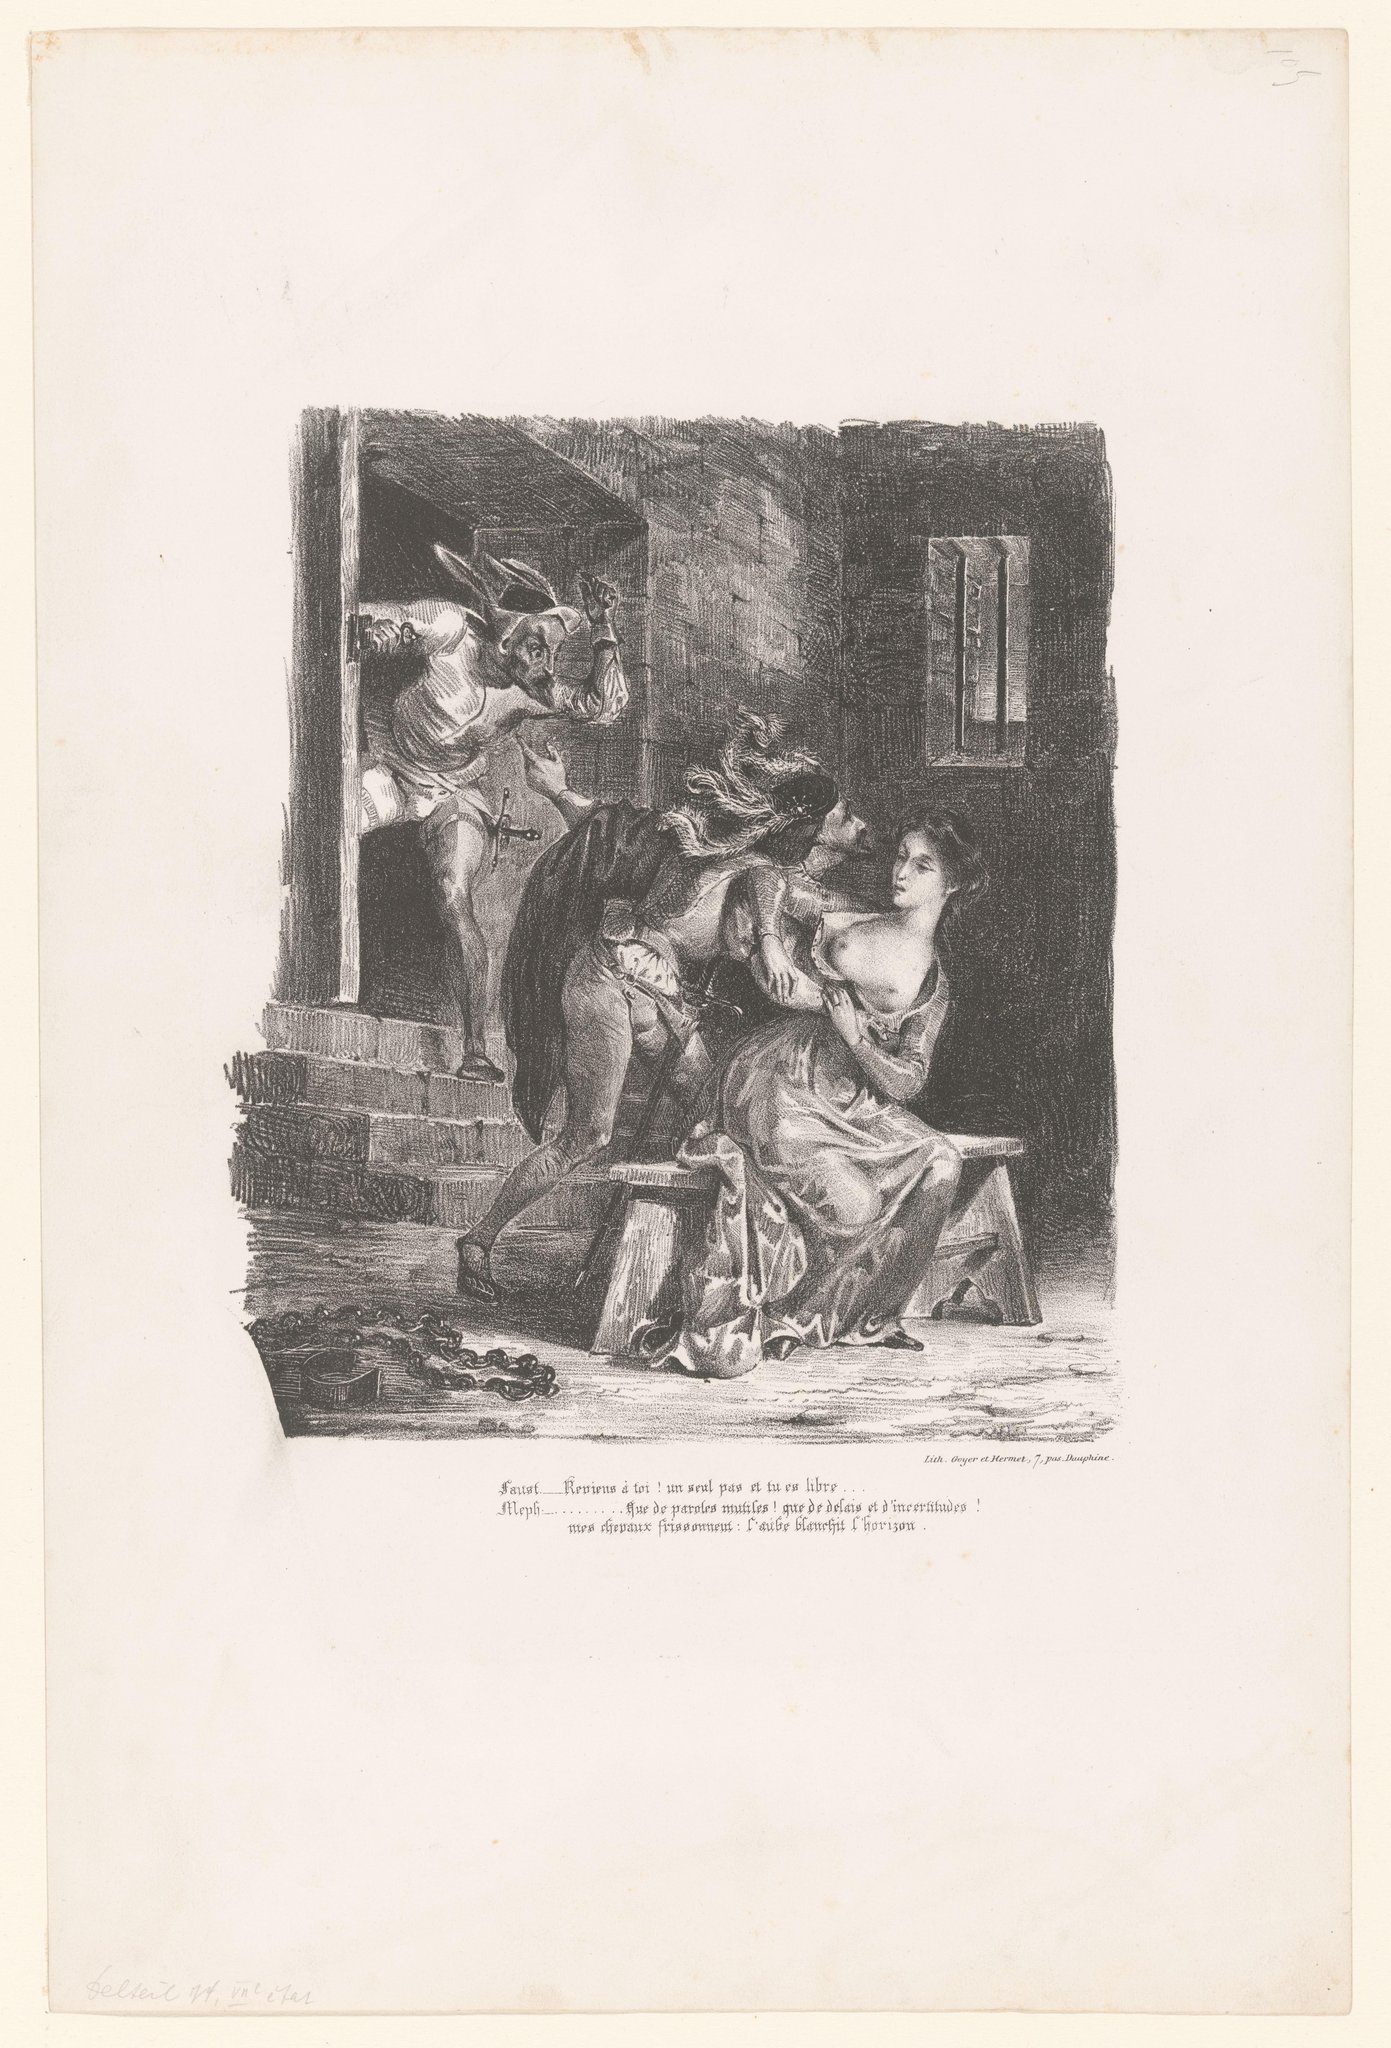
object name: print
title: Faust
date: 1828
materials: paper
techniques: lithograph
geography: paris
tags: (scenes from) specific works of literature: goethe, faust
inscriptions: collector's mark: Lugt 2228a, collector's mark: Lugt 964